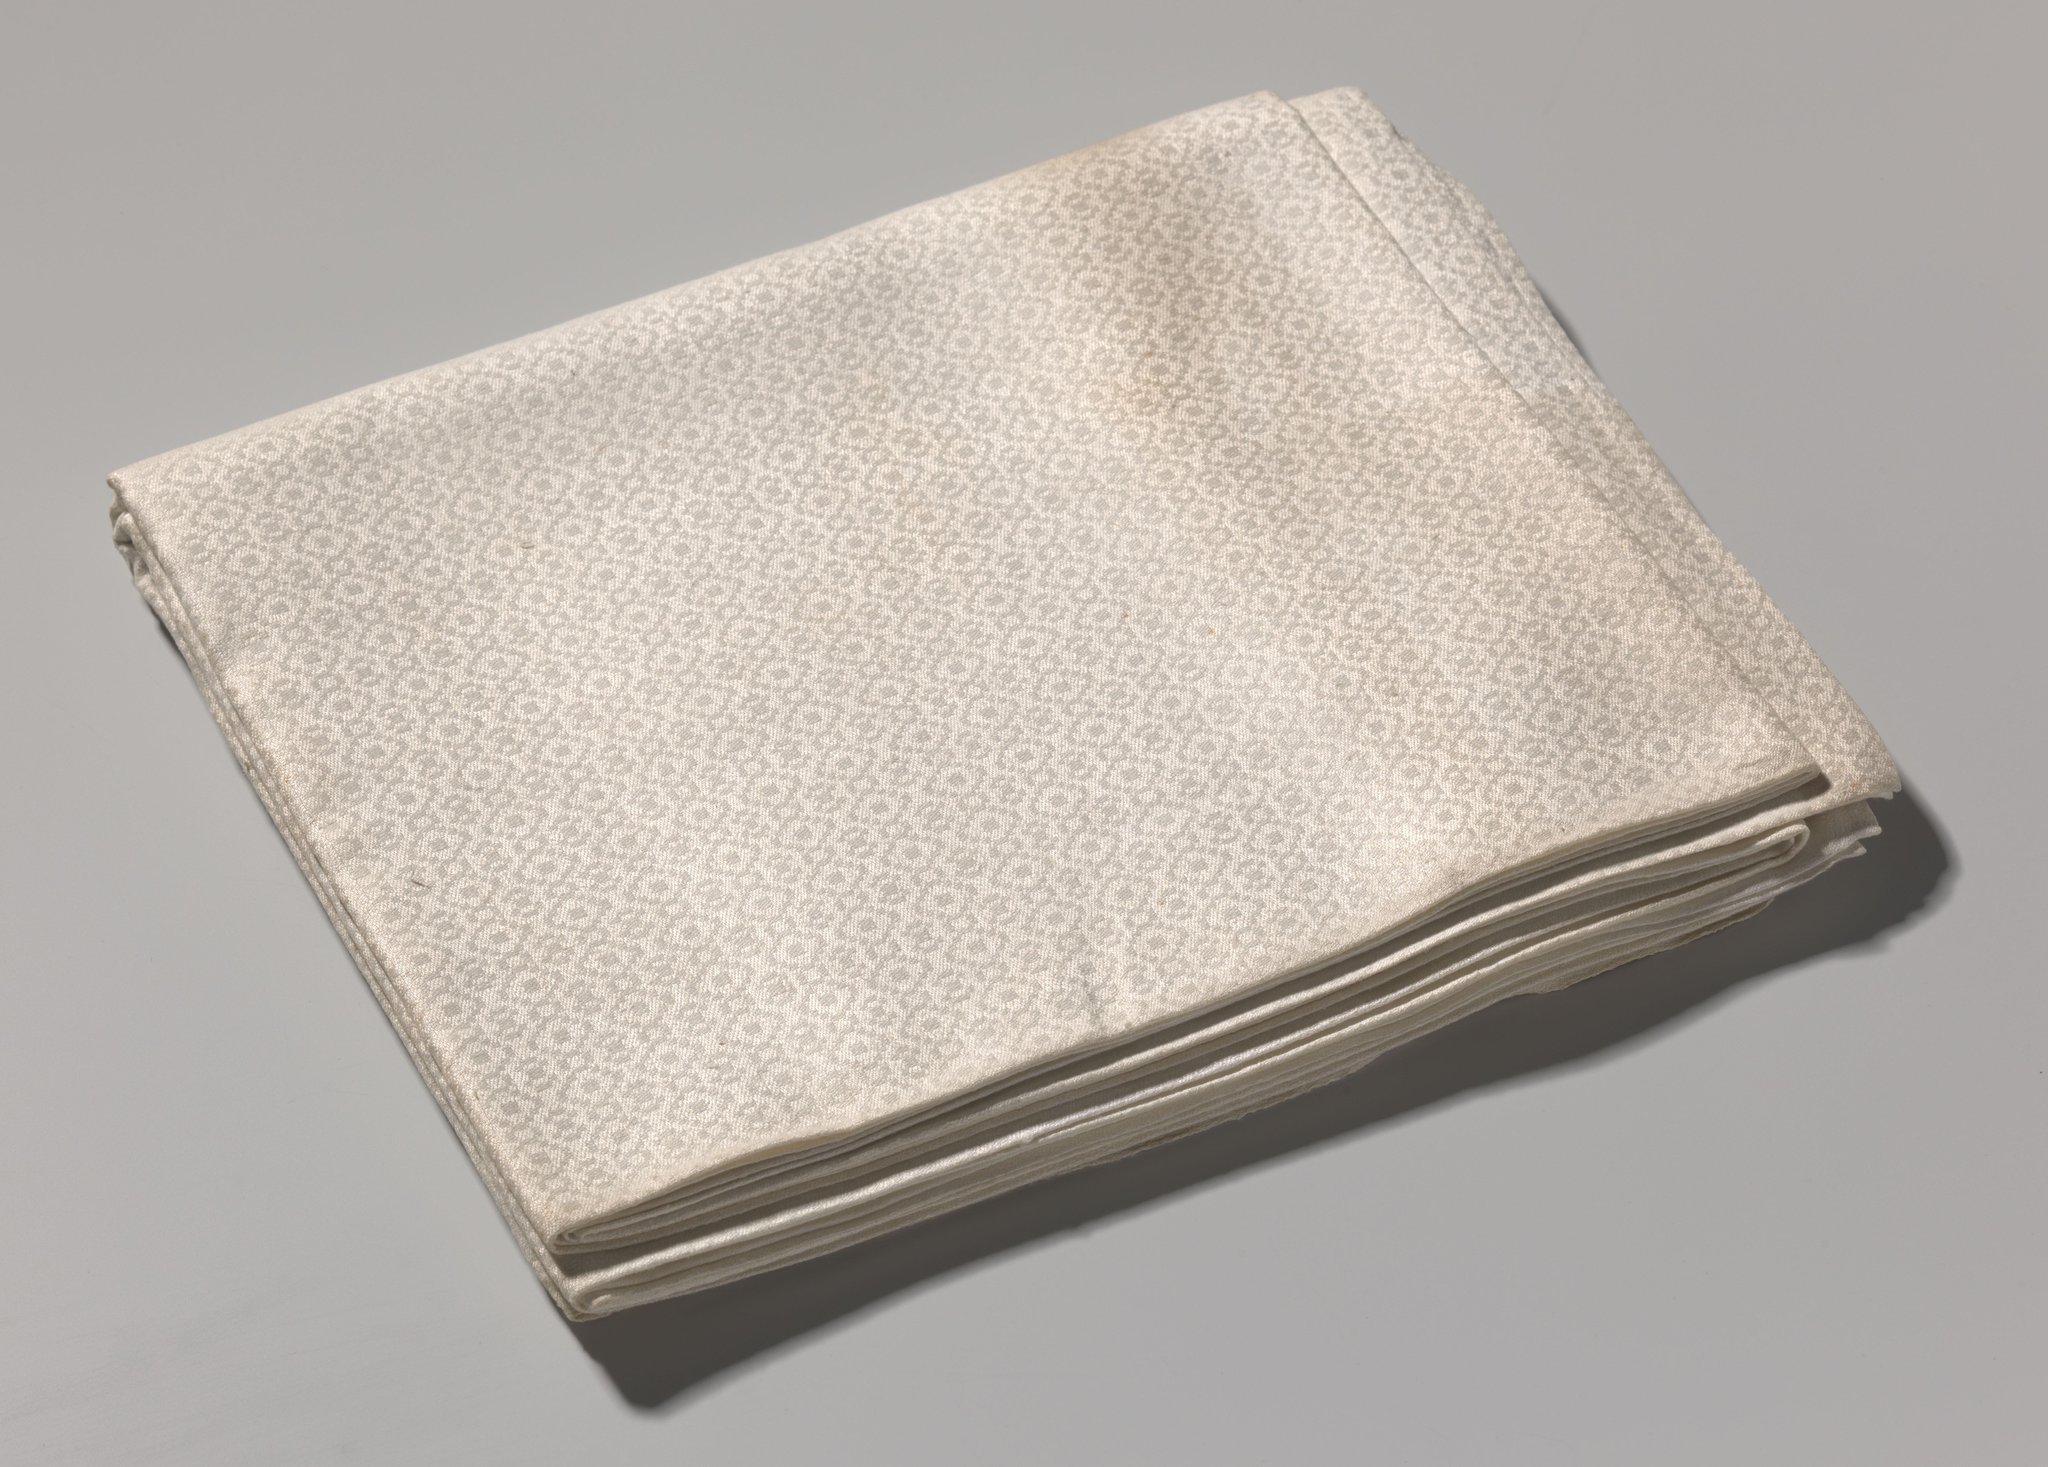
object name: tablecloth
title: Tafellaken met pellenpatroon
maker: Anonymous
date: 1400-1950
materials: linen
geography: northern netherlands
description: Tafellaken van wit linnendamast met pellenpatroon, merk kroon AVG 1.